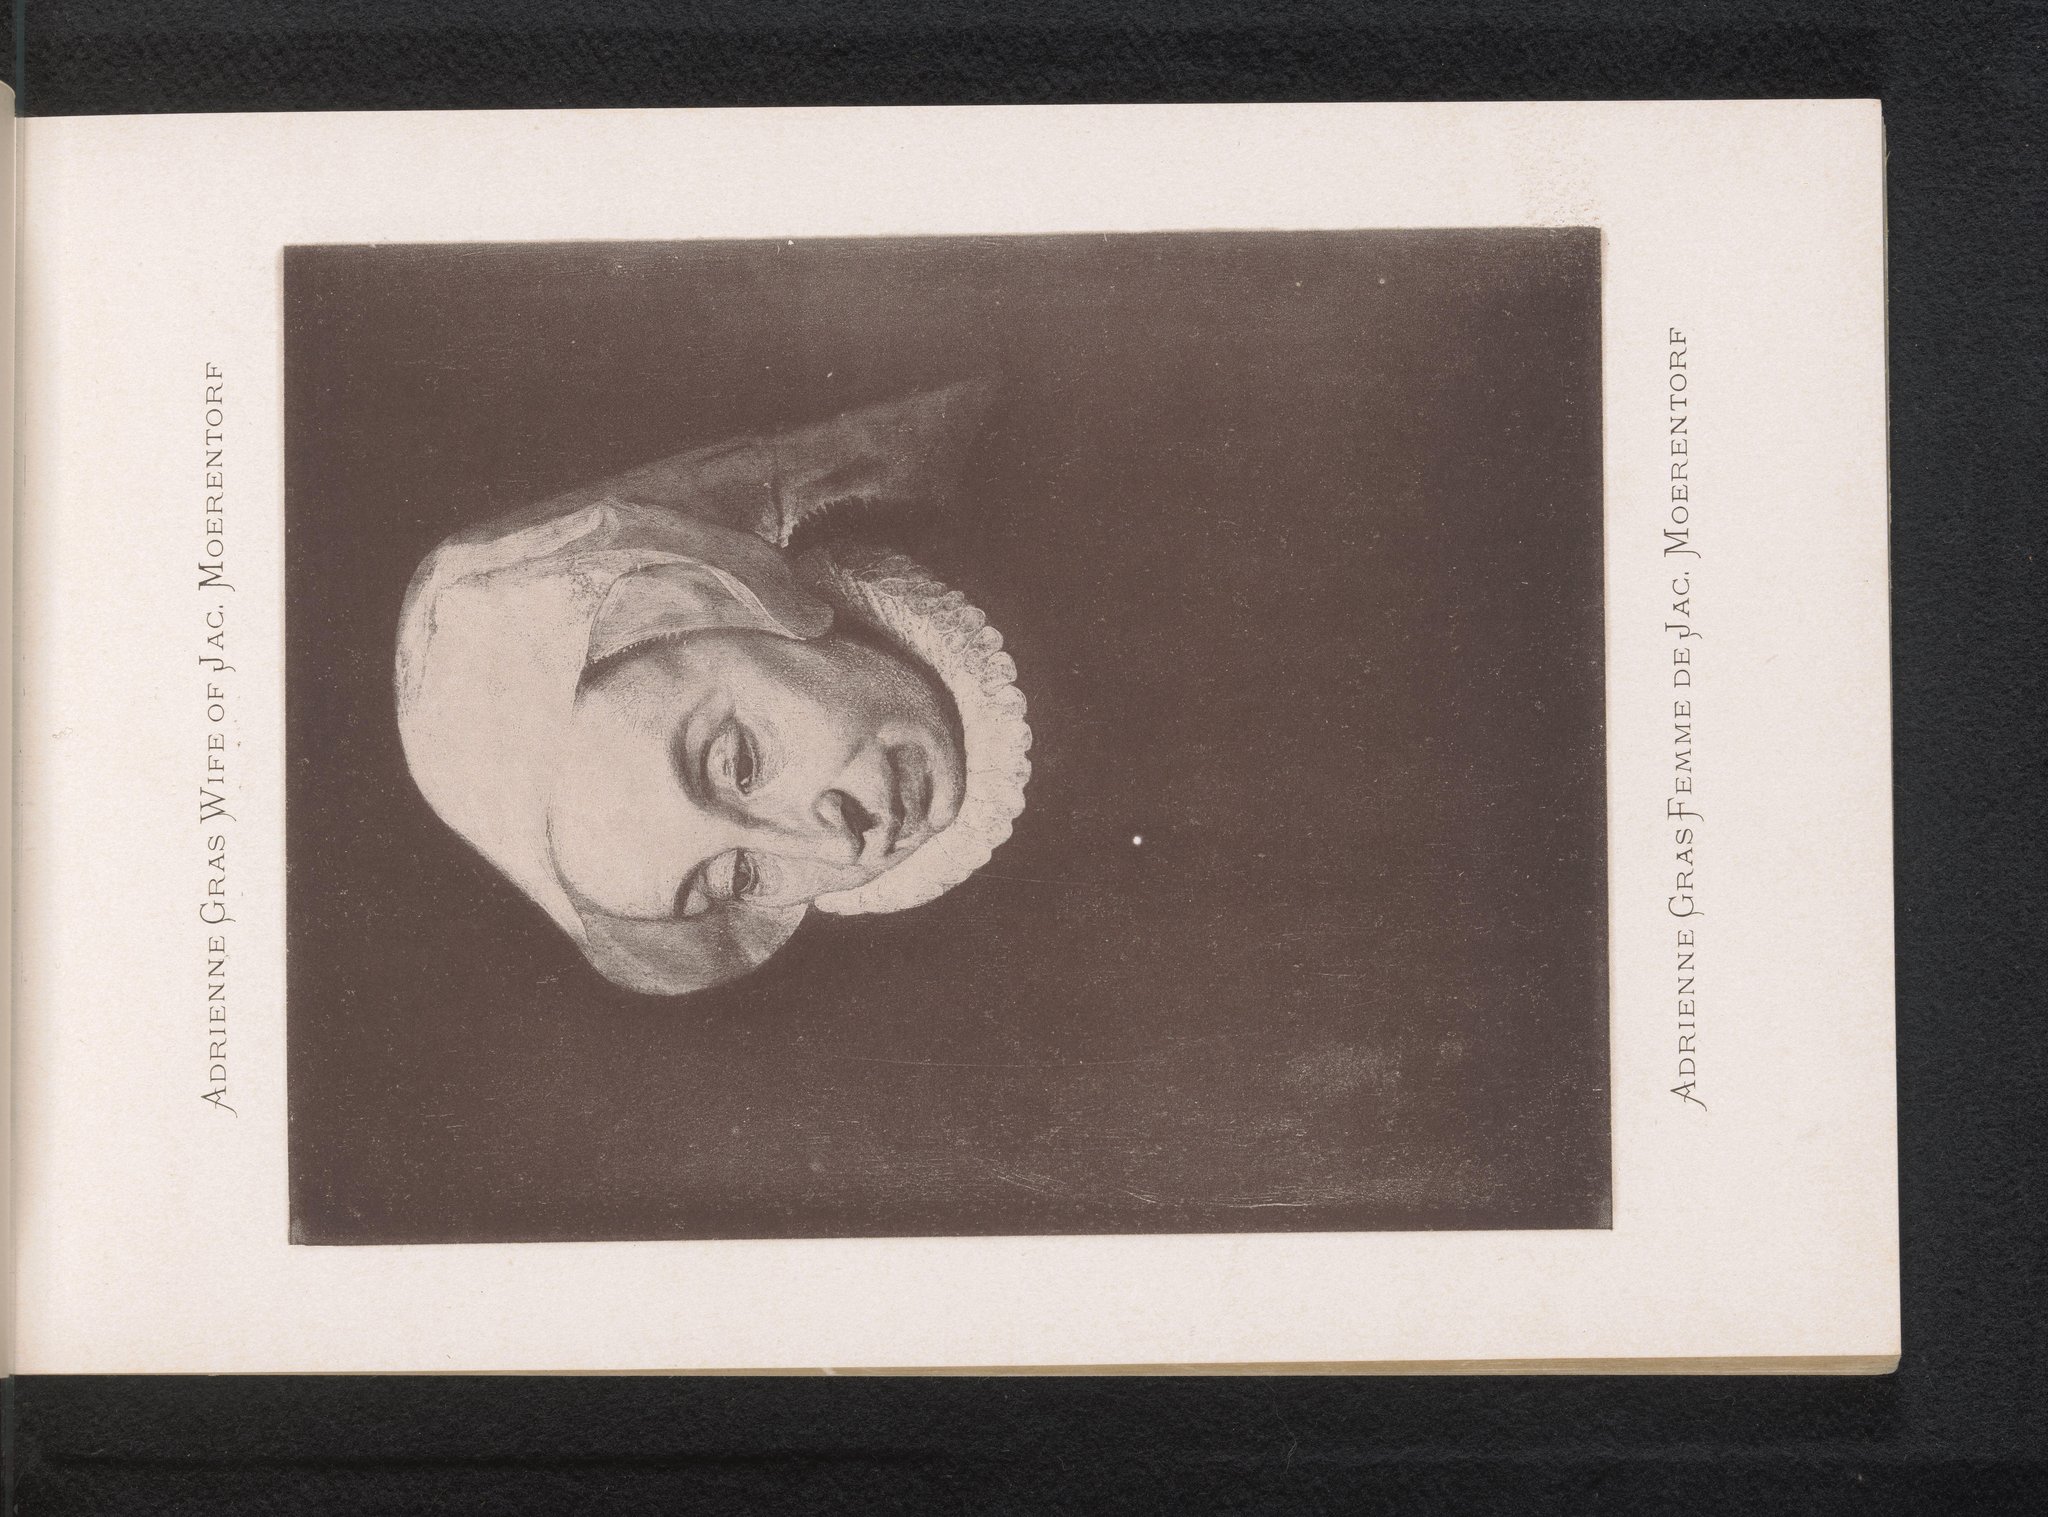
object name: page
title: Adrienne Gras wife of Jac. Moerentorf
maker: Anonymous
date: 1892-1897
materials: paper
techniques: photograph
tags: adult woman